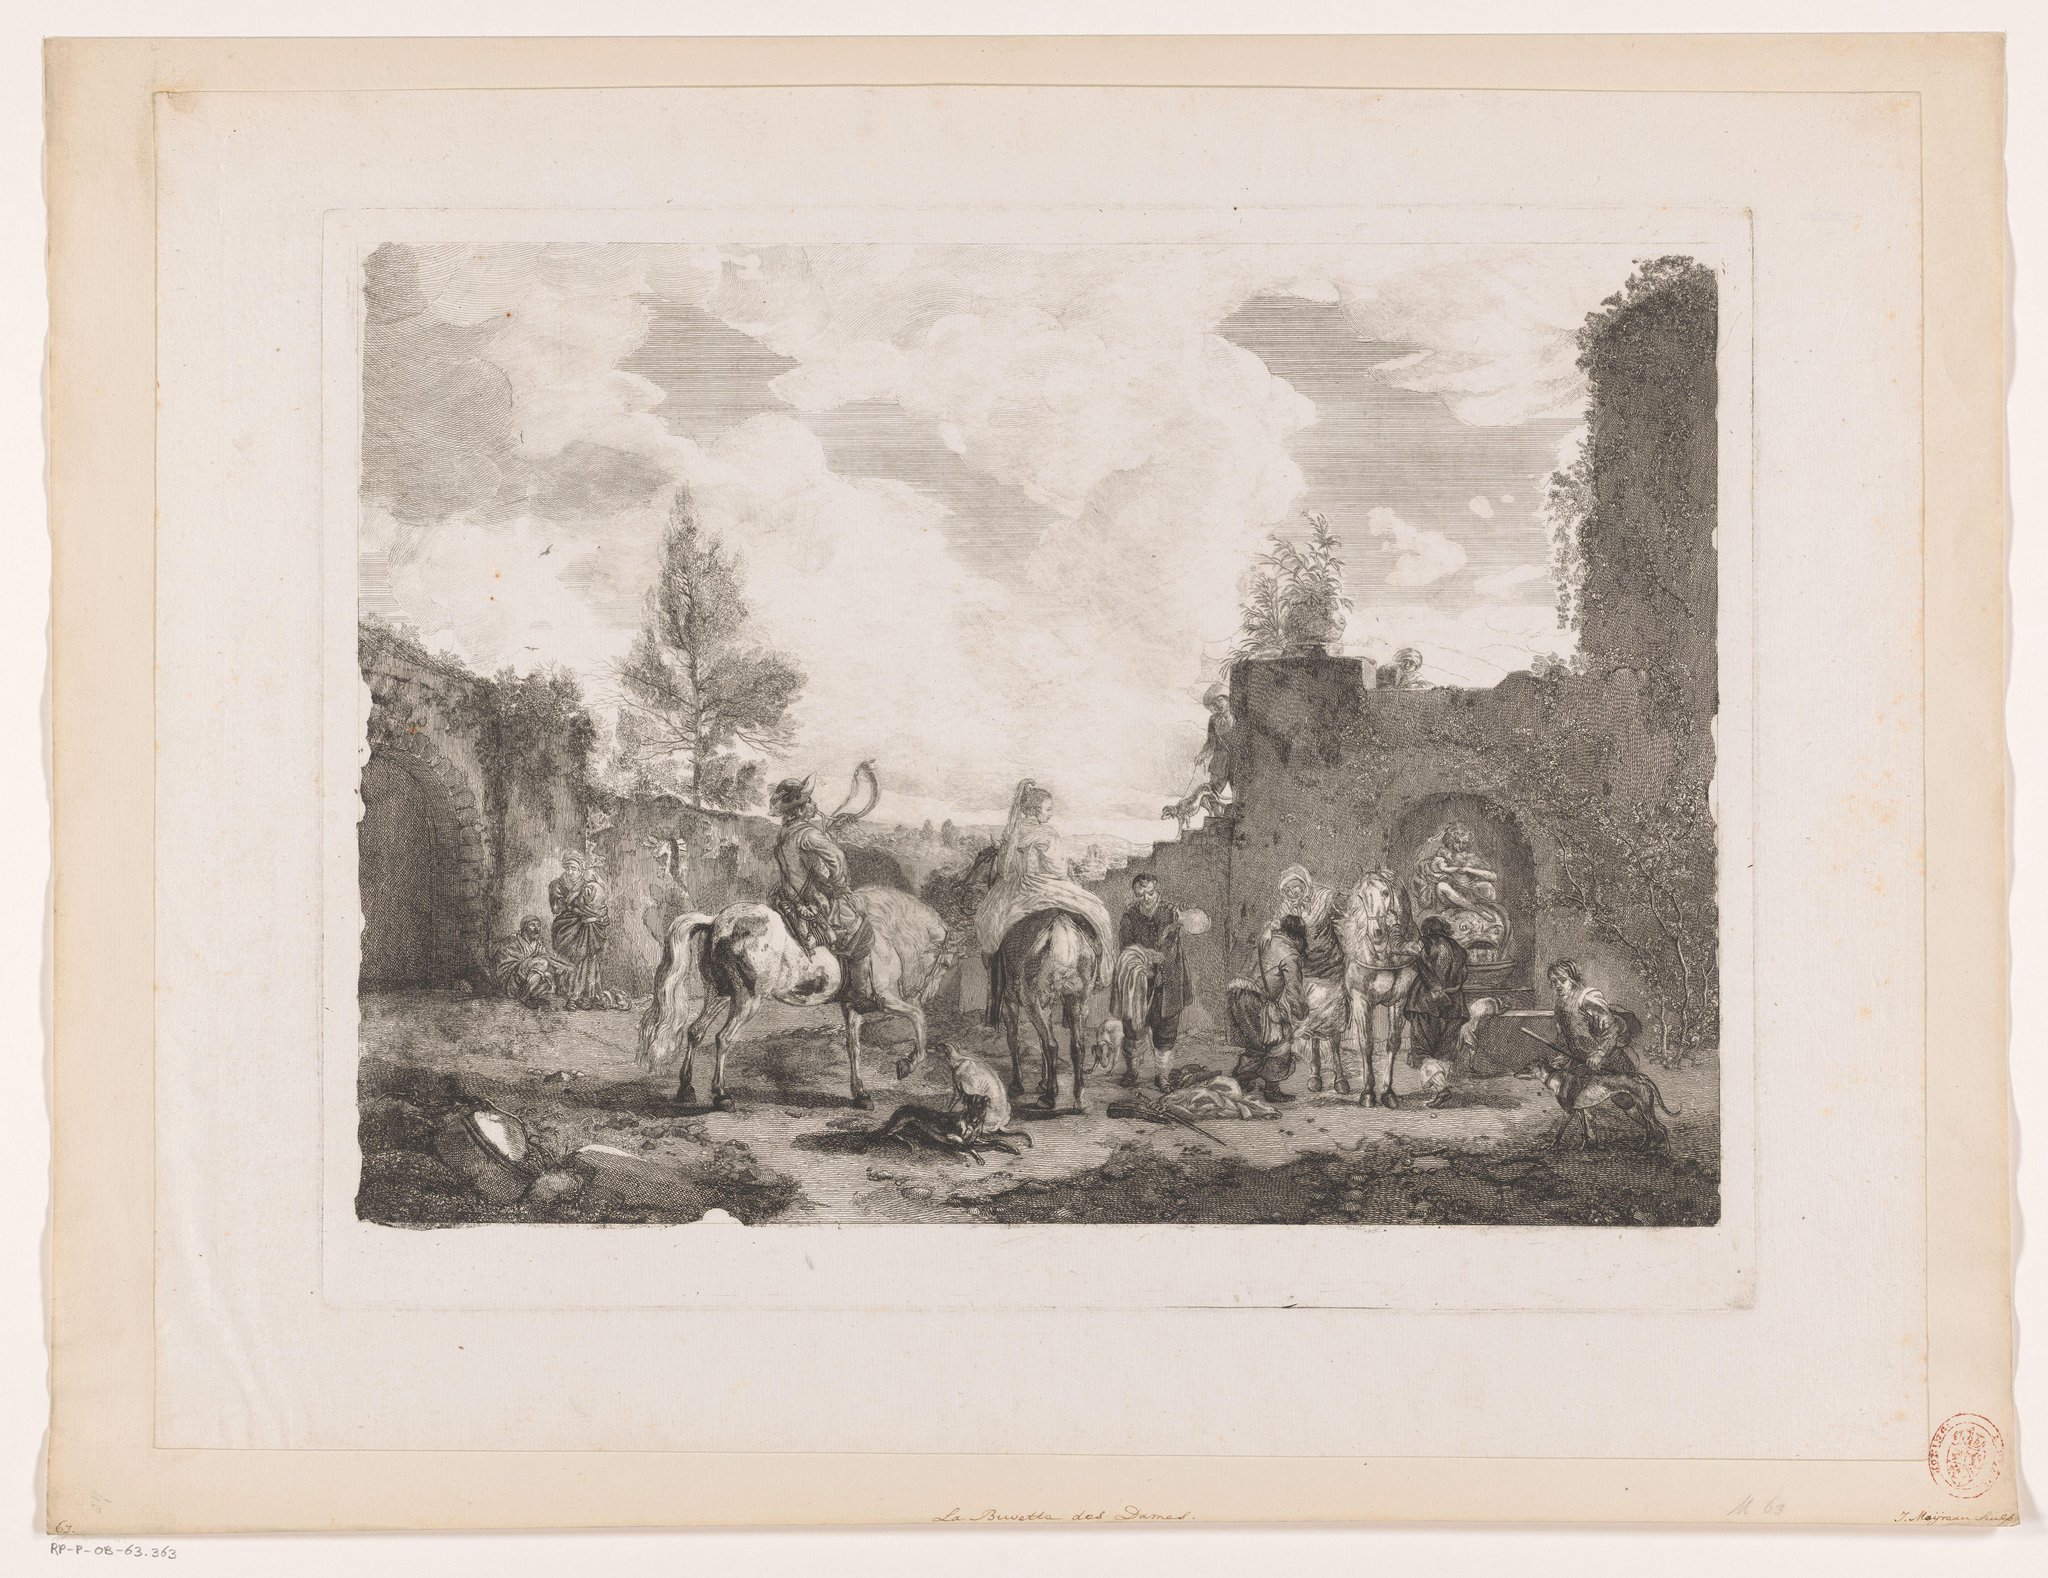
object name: print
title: La Buvette des Dames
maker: jean moyreau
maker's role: print maker, publisher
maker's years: 1690-1762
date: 1749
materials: paper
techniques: etching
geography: france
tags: hunters resting during the hunt, courtyard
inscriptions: collector's mark: Lugt 240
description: Maakt deel uit van een serie van 89 prenten te dateren tussen ca. 1733-1762, naar het geschilderde oeuvre van Philips Wouwerman. Dit betreft plaat 63.